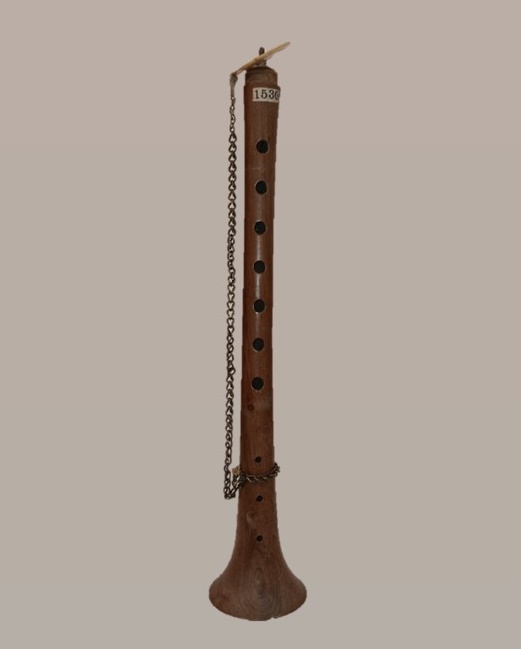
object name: zurna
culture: turkish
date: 1867-1900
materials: metal, wood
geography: turkey